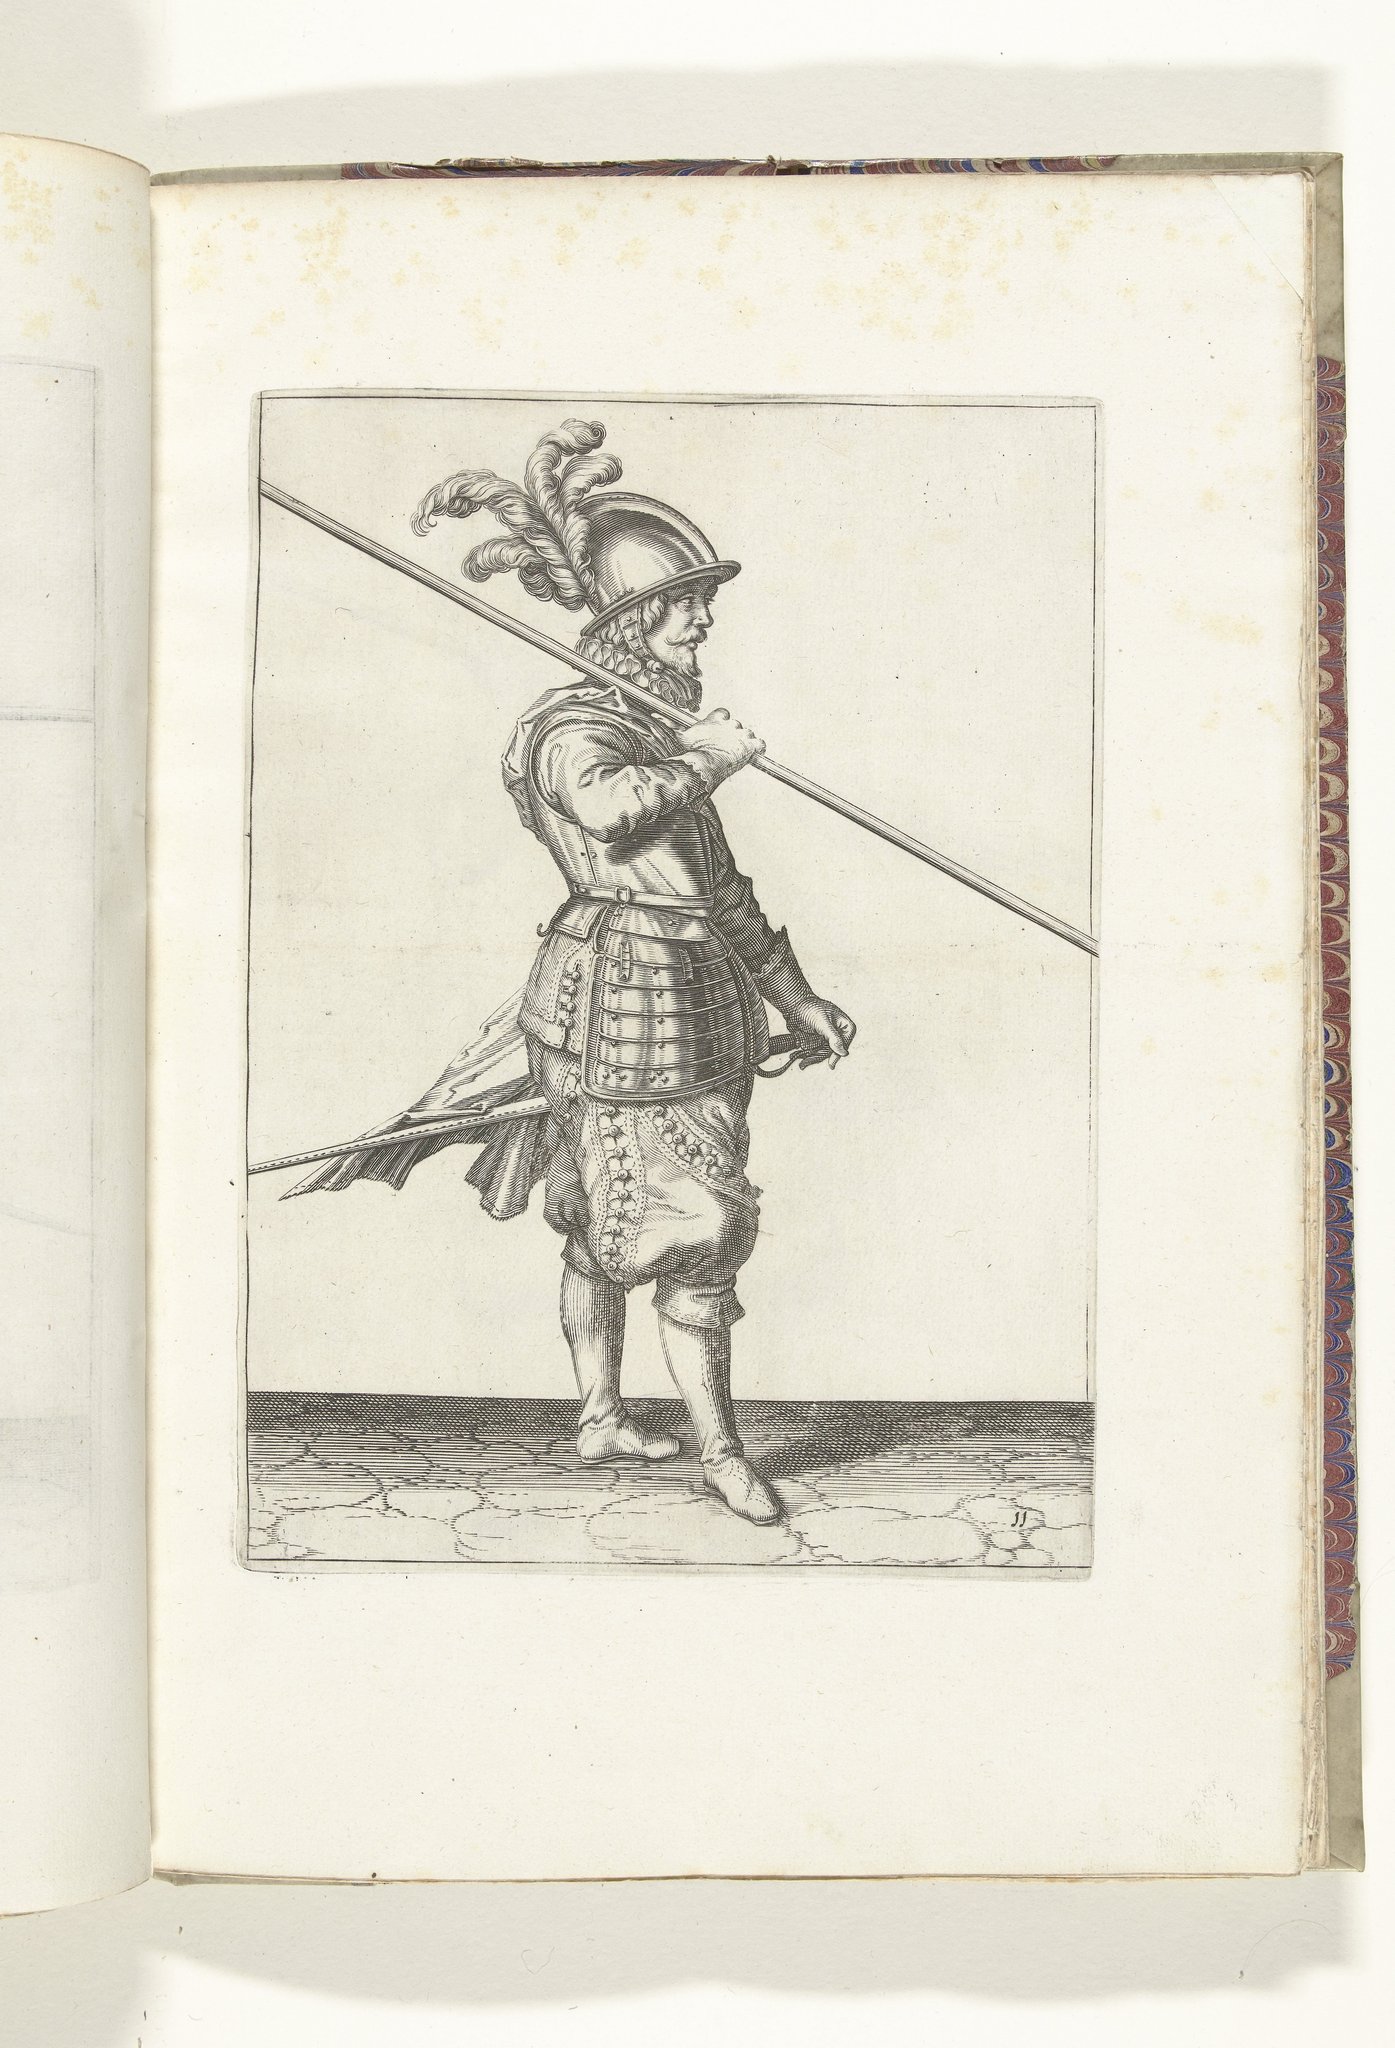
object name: print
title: Soldaat die zijn spies op zijn rechterschouder draagt, de punt schuin naar de grond gericht (nr. 11), ca. 1600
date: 1597-1607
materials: paper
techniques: engraving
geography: amsterdam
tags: maurice (prince of orange), handling of weapons ~ military training, weapons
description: Illustratie in: J. de Gheyn, Wapenhandelinghe van roers, musquetten ende spiessen achtervolgende de ordre van ... Maurits Prince van Orangie ..., R. de Baudous, Amsterdam 1608. Het derde deel (met afgesneden platen): Corte onderwysinghe op de figuerliicke afbeeldinghe belanghende trechte gebruck, van alle t'ghene een Soldaet int handelen vande Spies noodich is, plaat 11. Dit exemplaar bevat alleen de tekstbladen voor het tweede en derde deel. In het exemplaar in de collectie van de Rijksmuseum Research Library (326 F 16).